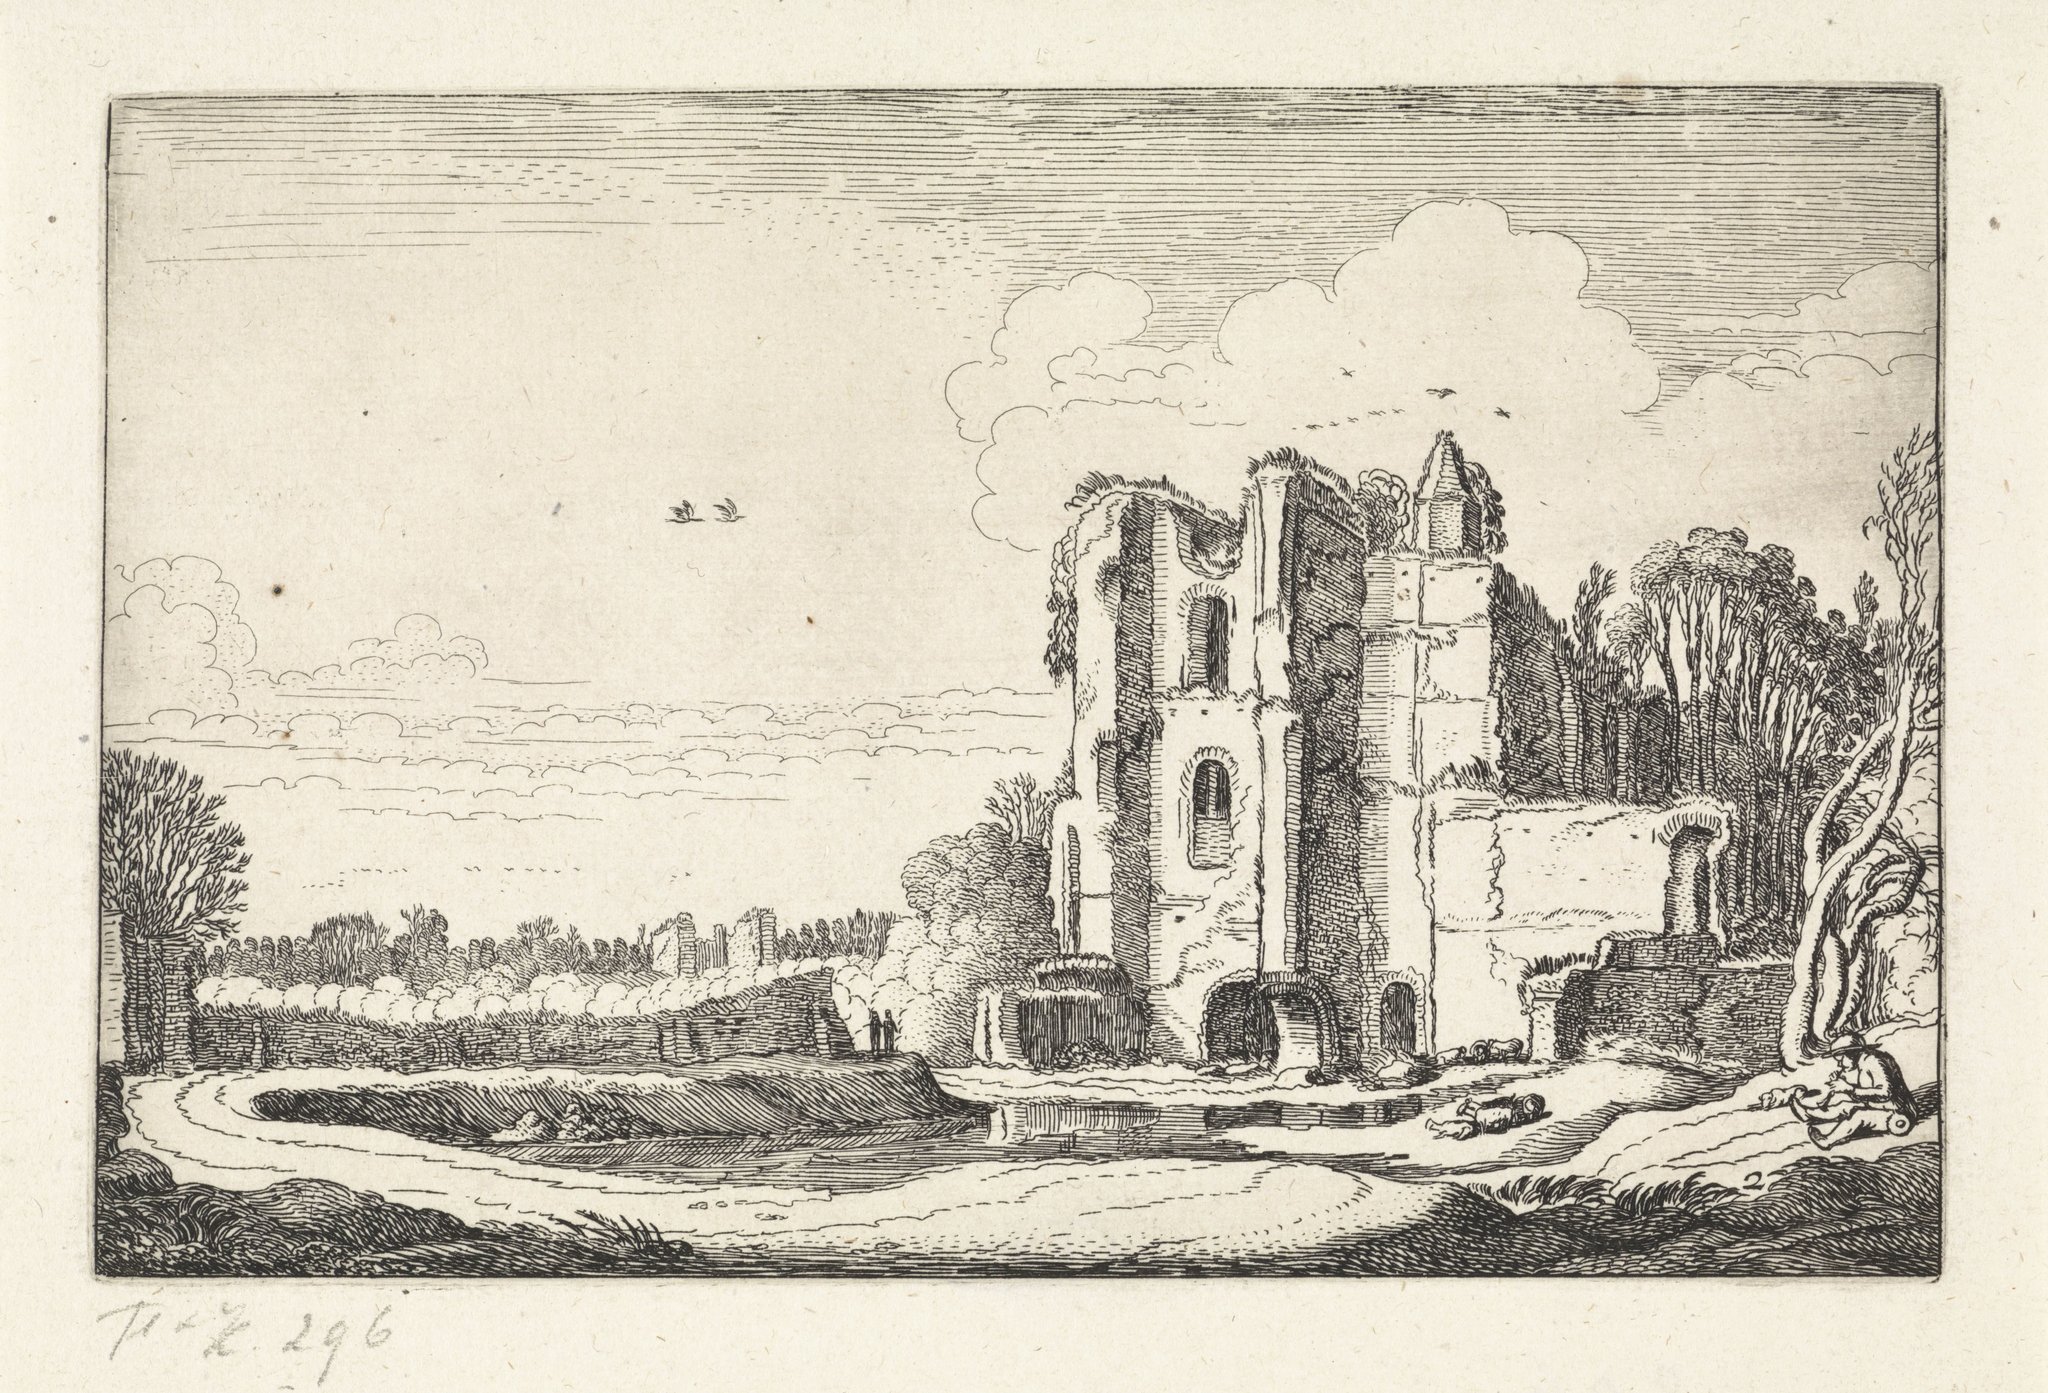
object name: print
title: Landschappen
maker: jan van de velde (ii)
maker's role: draughtsman, painter, print maker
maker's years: 1593-1641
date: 1616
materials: paper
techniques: etching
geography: northern netherlands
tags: landscape with ruins, ruin of a dwelling, house, castle, etc.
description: Oorspronkelijk vormden de eerste staten van de prenten een serie bestaande uit twee delen van elk 26 prenten. De latere staten vormden een serie van vijf delen van elk twaalf prenten.